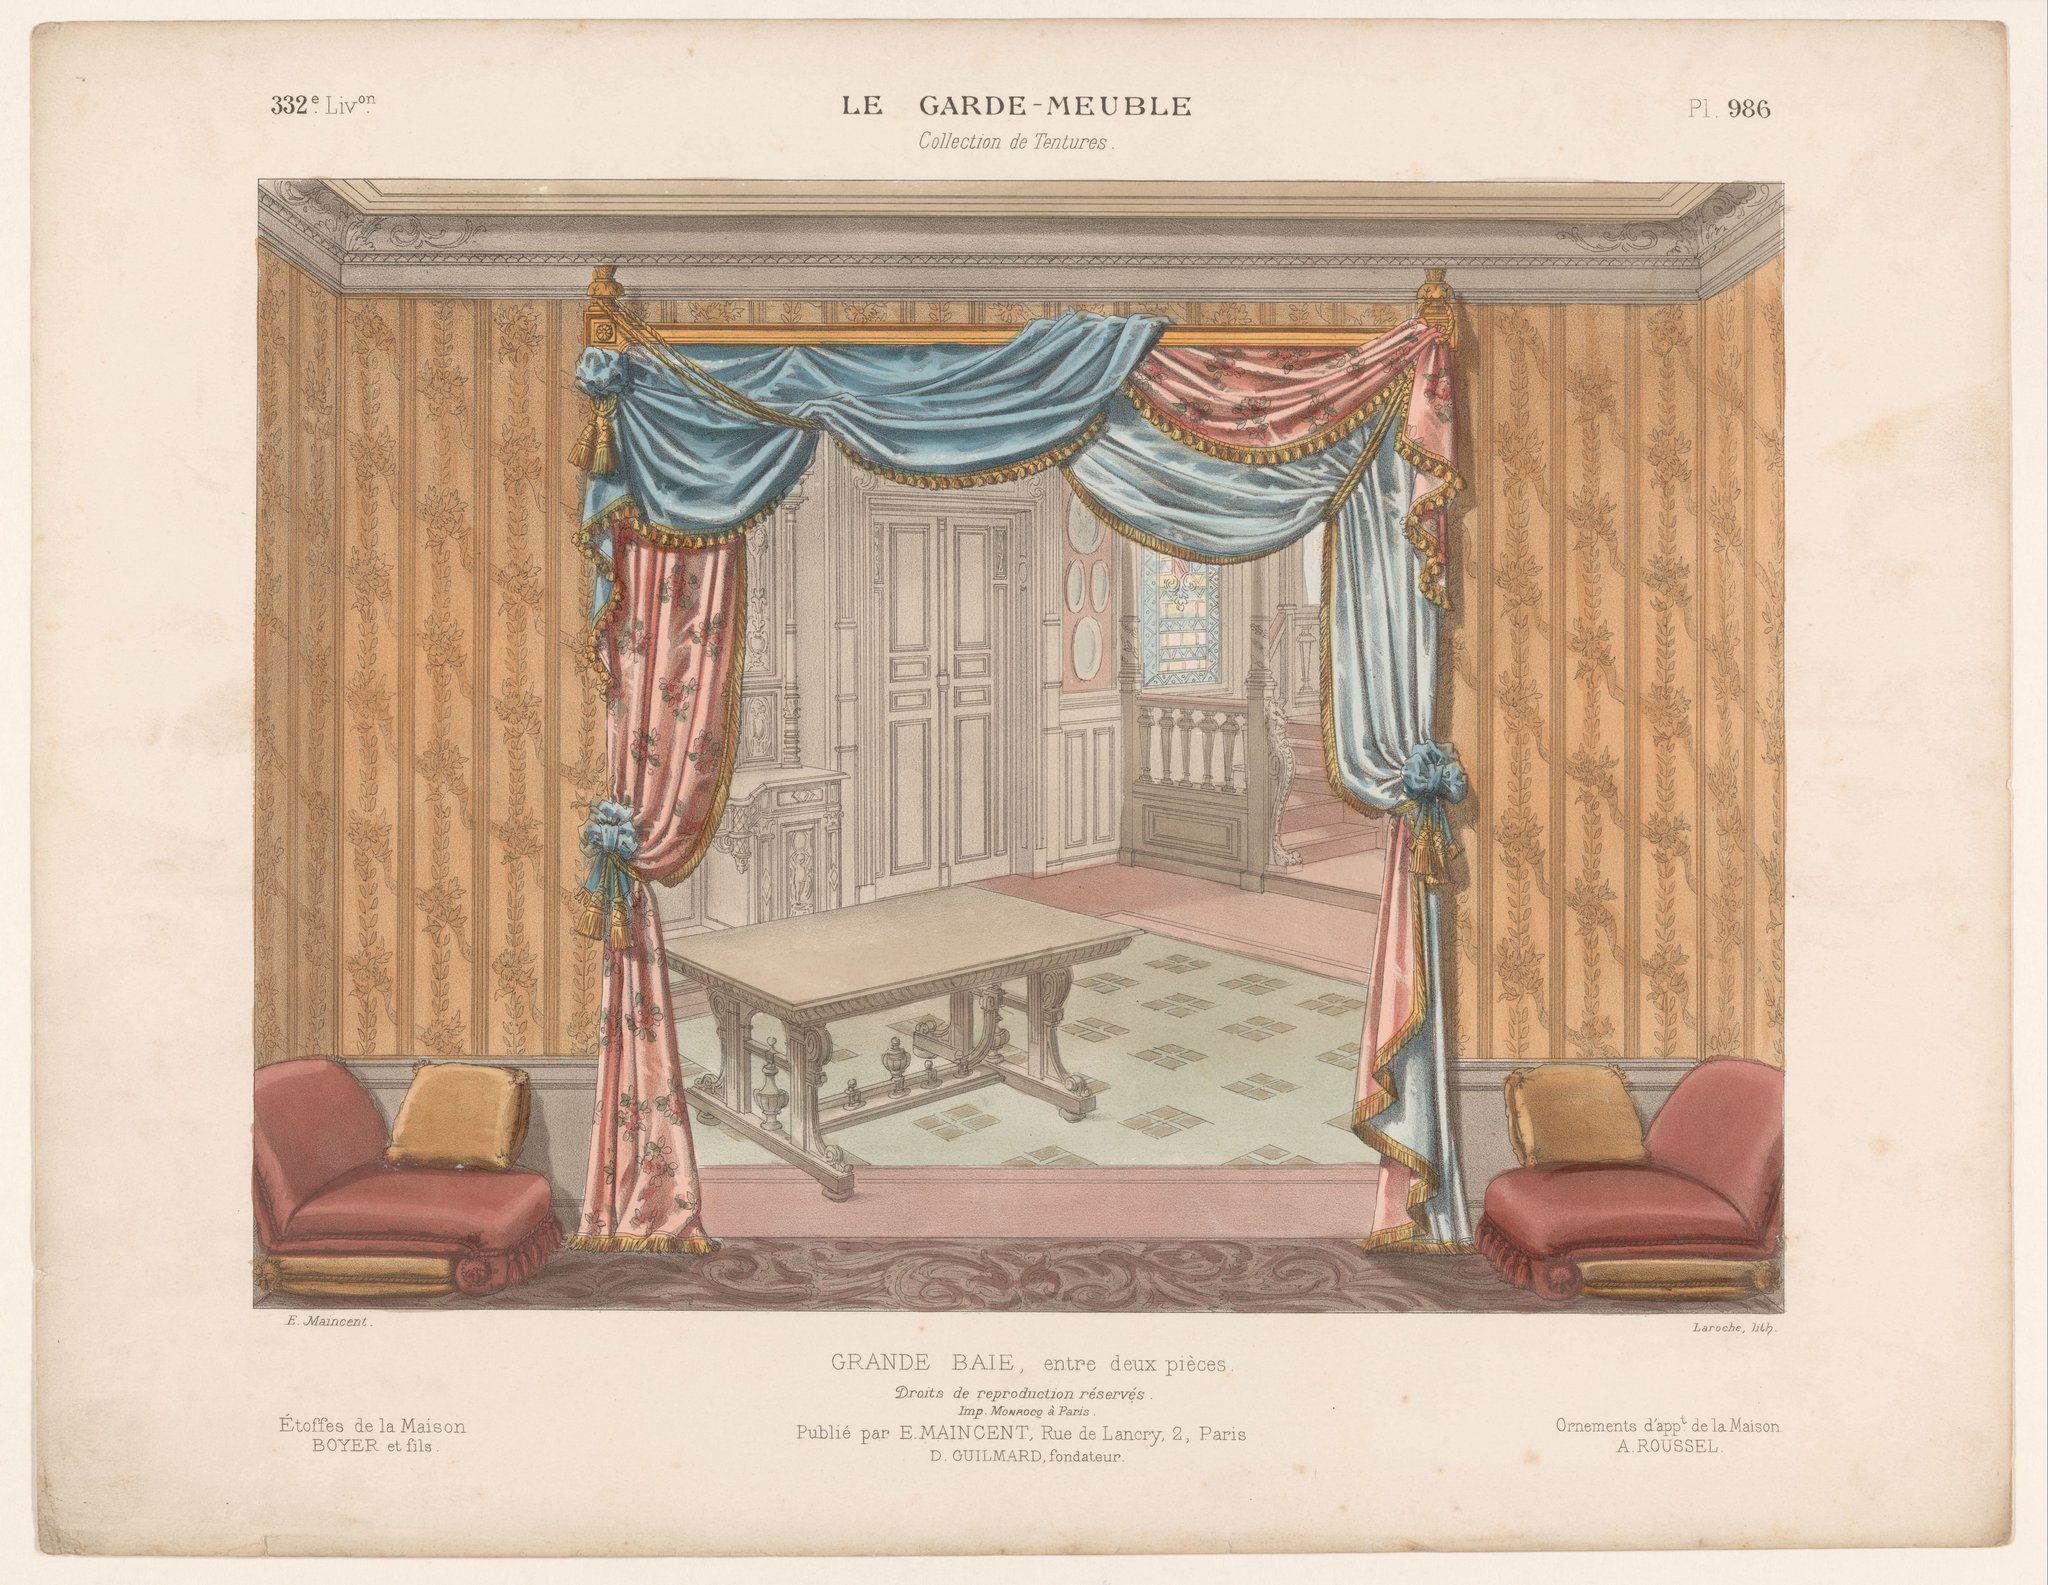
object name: print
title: Grande Baie entre deux Pièces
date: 1885-1895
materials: paper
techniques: hand coloring, lithograph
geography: paris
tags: decorations (interior of the house), door, hangings and drapery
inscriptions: : ‘Droits de reproduction réservés.’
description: Grote doorgang met gedrapeerde gordijnen tussen twee vertrekken. Prent uit 332e Livraison.